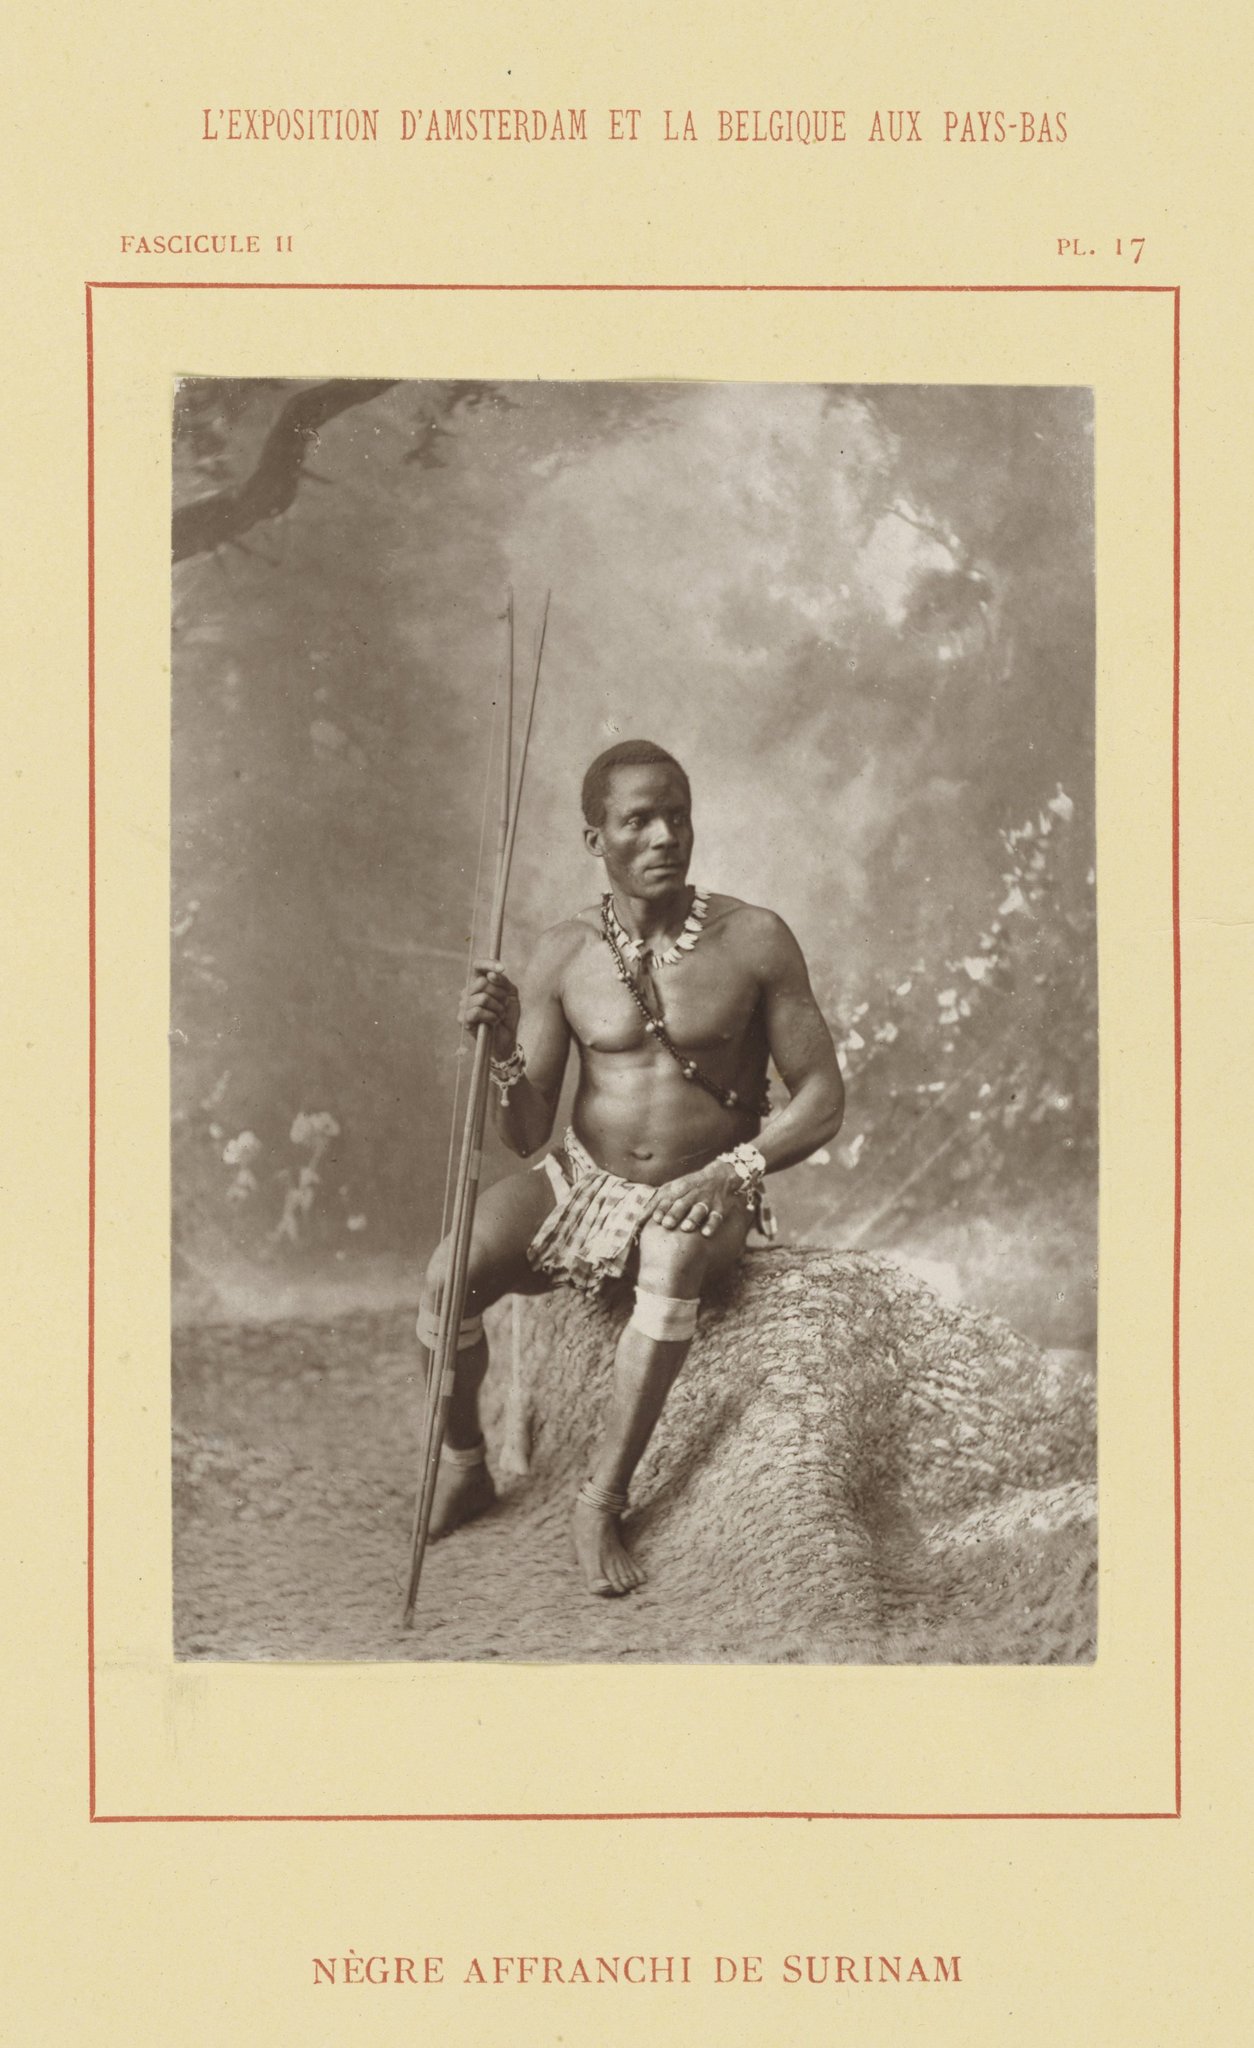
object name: photograph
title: Portret van Kojo A Slen Gri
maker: théophile fumière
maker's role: publisher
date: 1883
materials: cardboard, paper, photographic support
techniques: woodburytype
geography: amsterdam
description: Fascicule II pl. 17 uit L'exposition d'Amsterdam et la Belgique aux Pays-Bas, 1883.